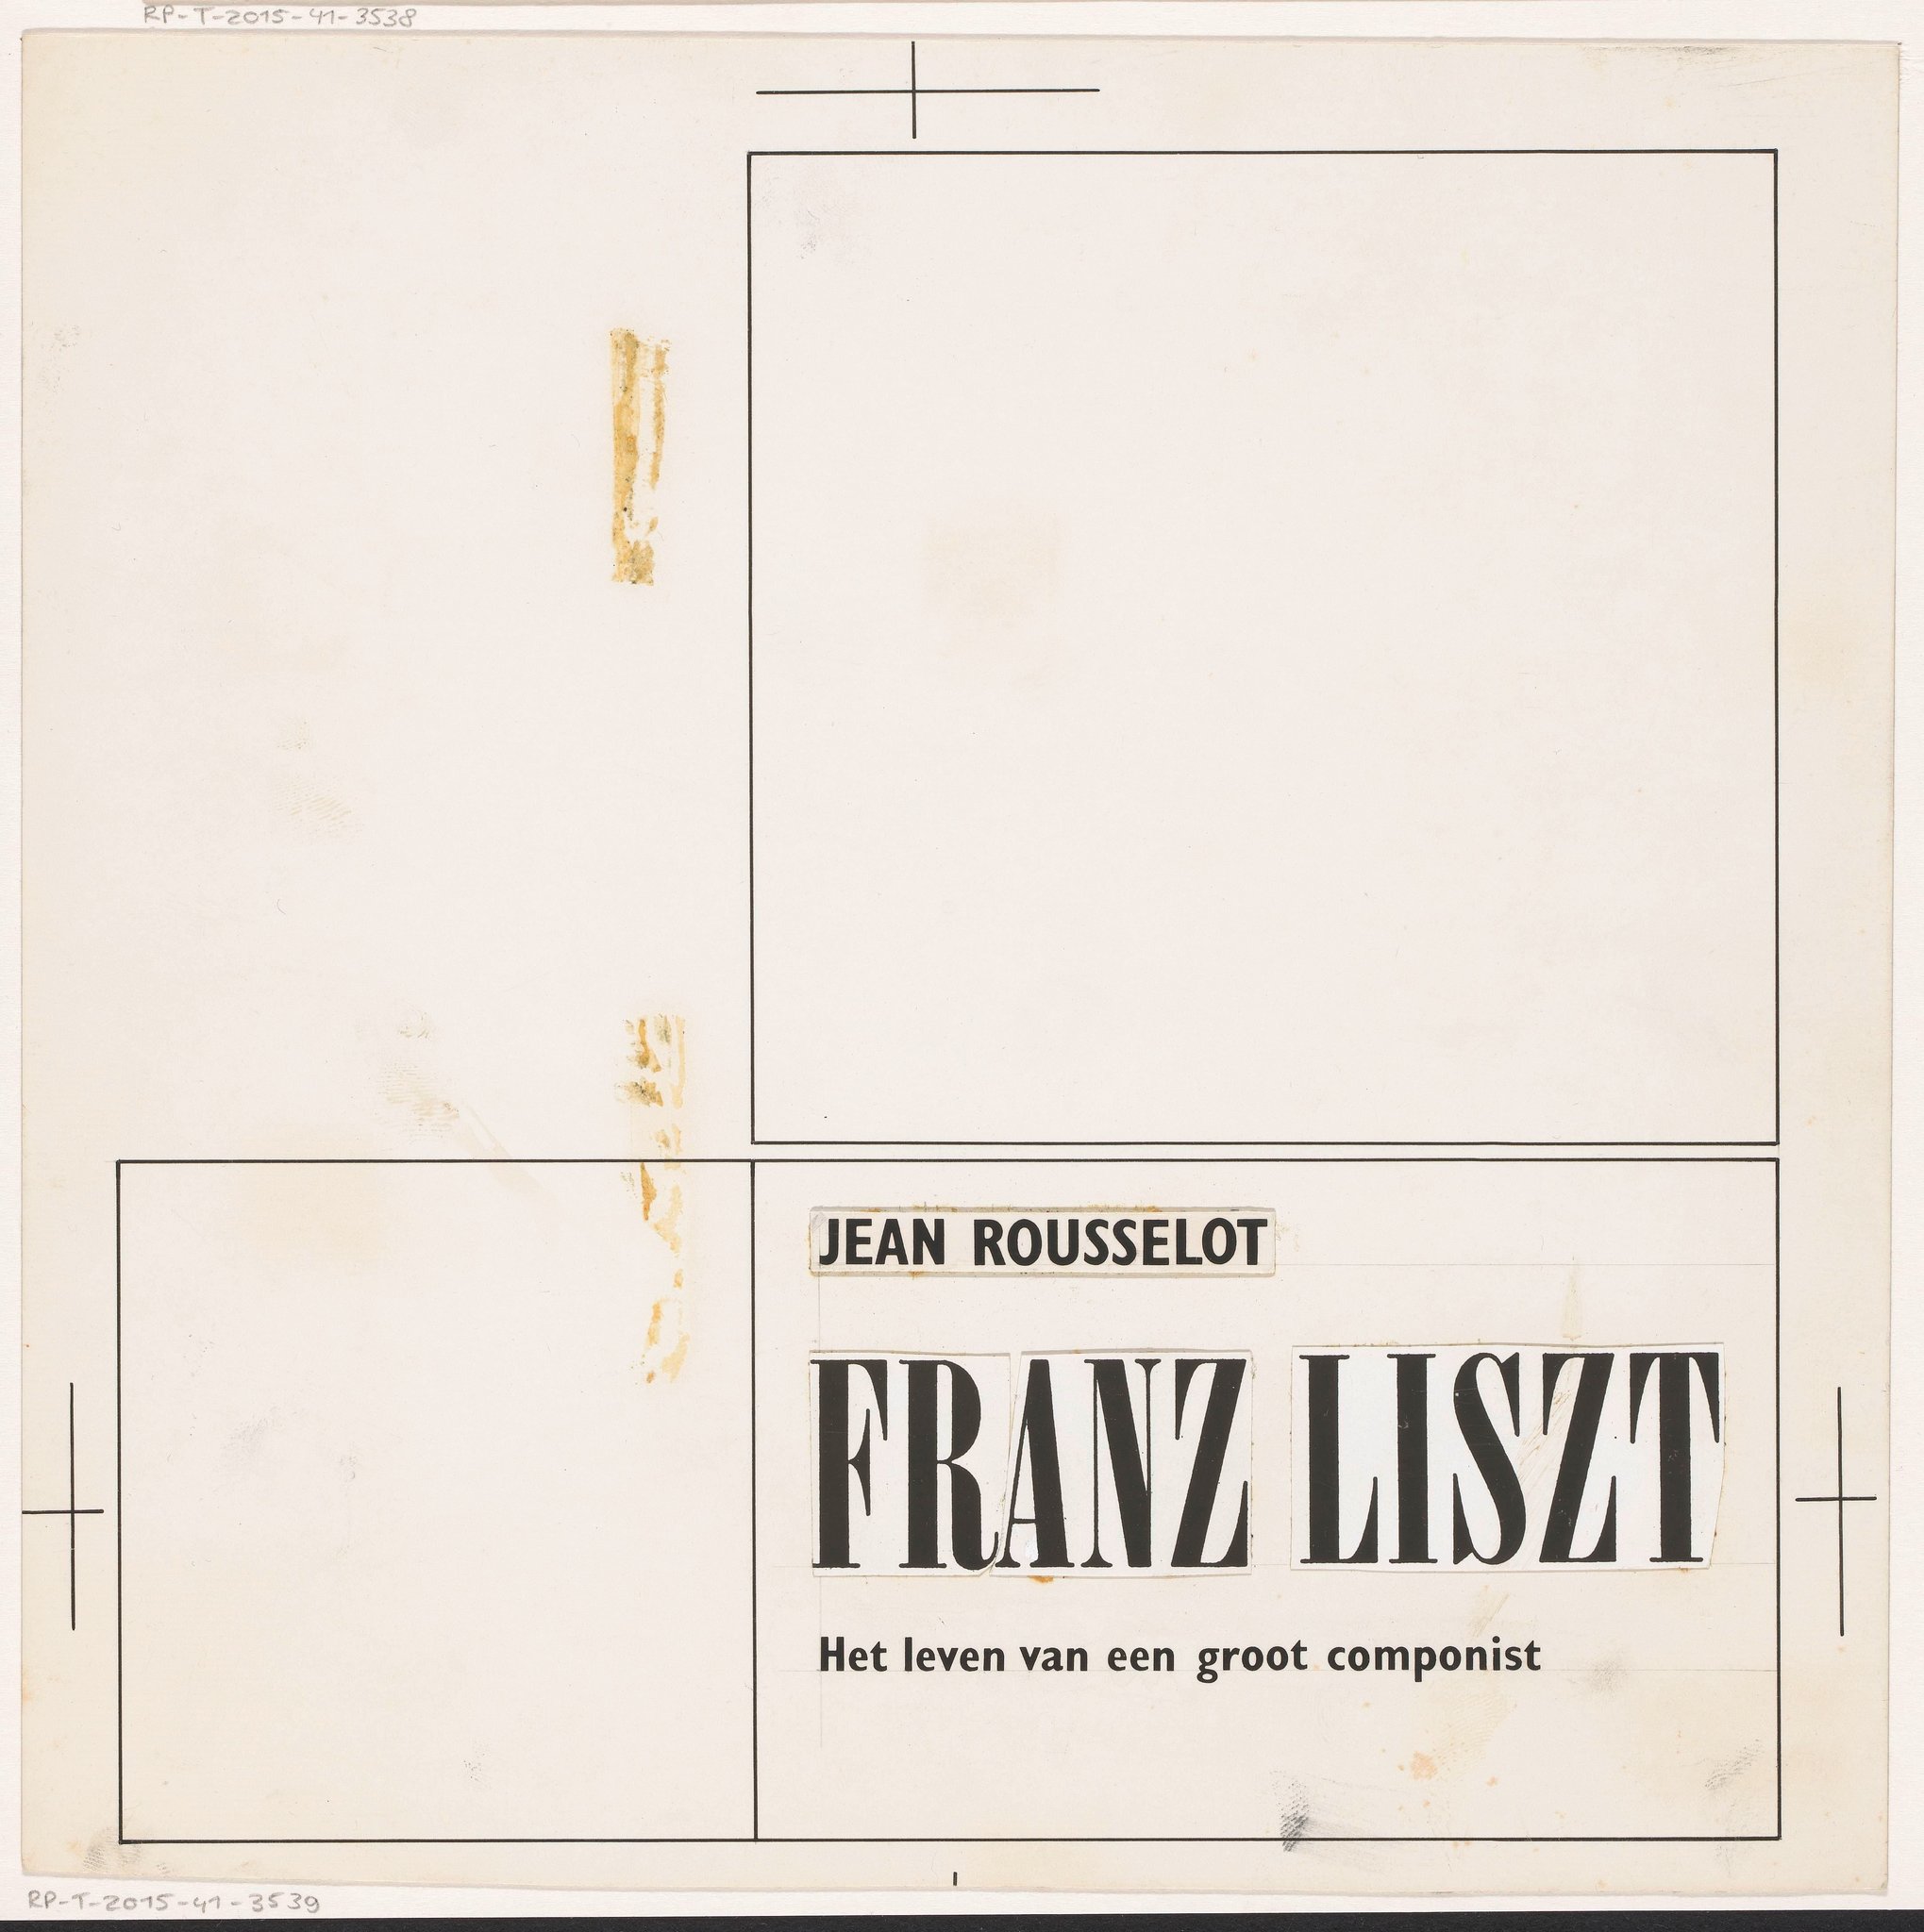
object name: drawing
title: Bandontwerp voor: Jean Rousselot, Frans Liszt. Het leven van een groot componist, c. 1961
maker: Anonymous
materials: cardboard, ink, paper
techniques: pen, printing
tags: fancy letters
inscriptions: collector's mark: Lugt 2228a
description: Ontwerp voor lettertypen en de plaatsing van tekst en afbeeldingen op de band.